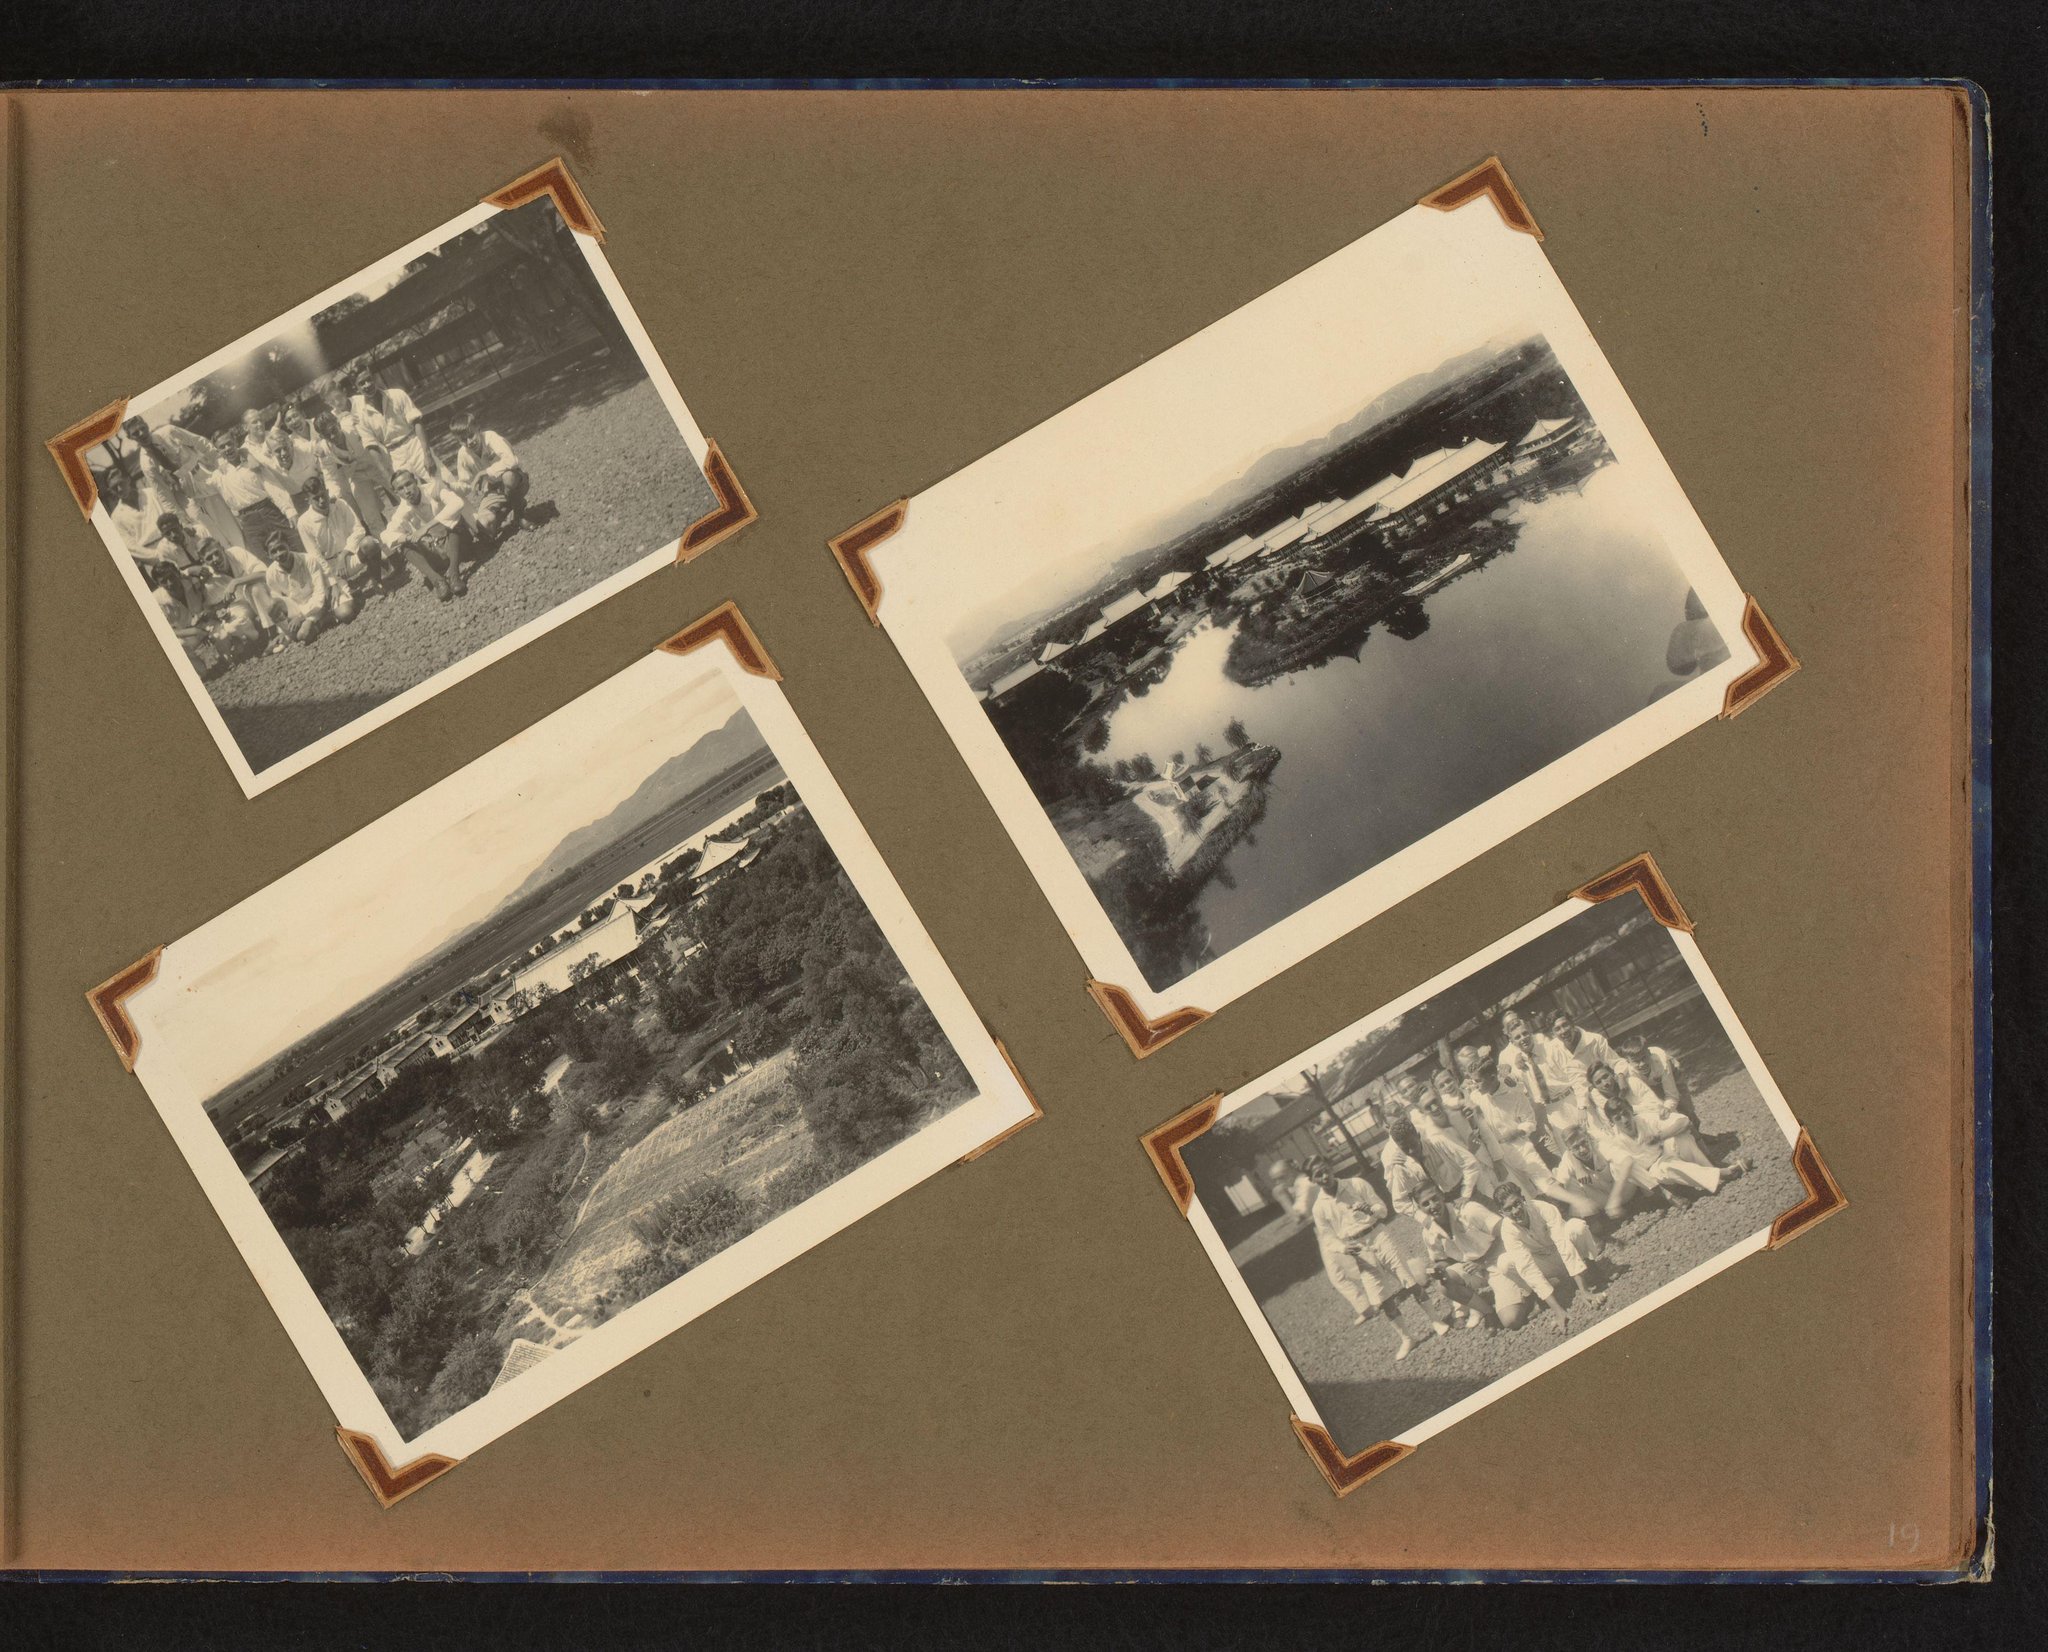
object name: album leaf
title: Yenching University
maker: Anonymous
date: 1935-1936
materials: cardboard, photographic support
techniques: gelatin silver print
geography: beijing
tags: university, student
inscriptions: inscription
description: Albumblad met vier foto's van de gebouwen van Yenching University in Beijing, China, en van groepen studenten. Onderdeel van een familiealbum van een Chinees-Indische familie in Weltevreden, ca. 1935.